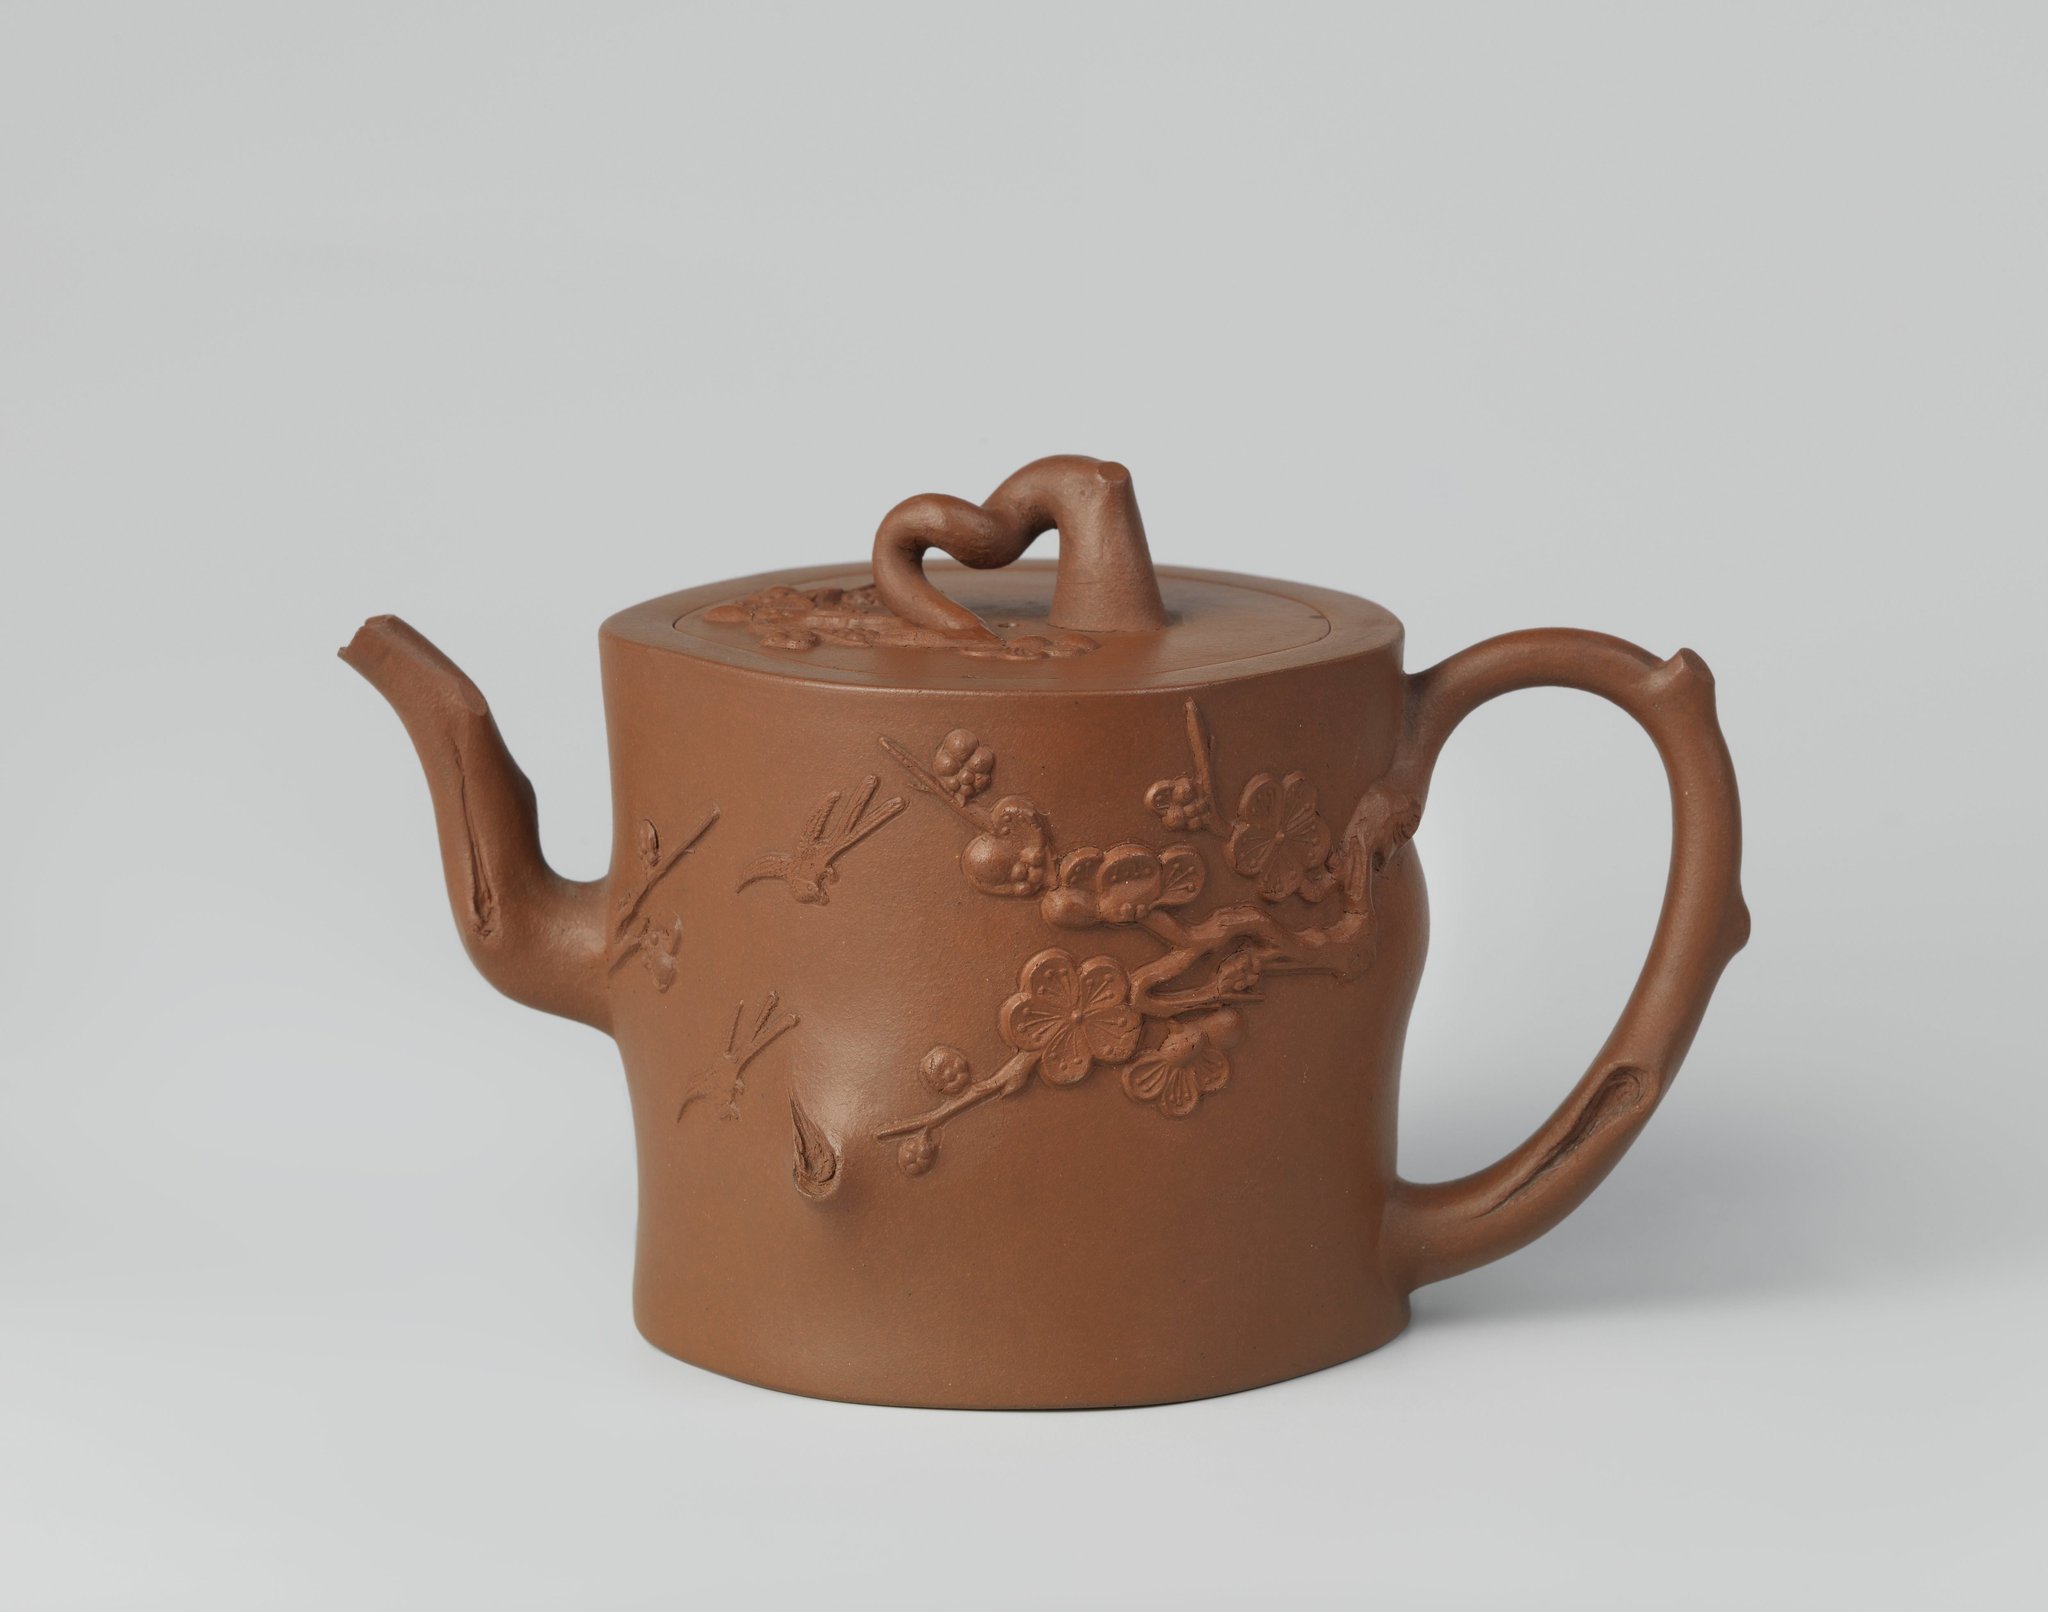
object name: teapot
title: Teapot with prunus sprays, birds and a butterfly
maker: Anonymous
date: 1700-1799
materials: stoneware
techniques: firing, forming, relief, turning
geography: china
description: Theepot van rood steengoed met een cilindervormig lichaam, gemodelleerd in de vorm van een schijf van een dik stuk bamboe, gebogen tuit en C-vormig oor. Op de wand prunustakken, vogels en een vlinder. De platte deksel met prunustakken. Tuit, oor en dekselknop in de vorm van knoestige takken. Yixing.